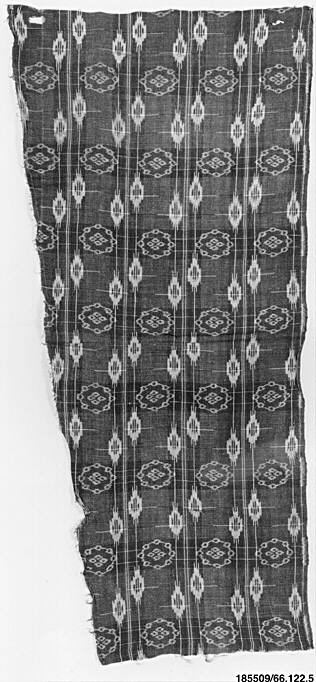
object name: piece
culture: japanese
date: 1801-1900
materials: hemp